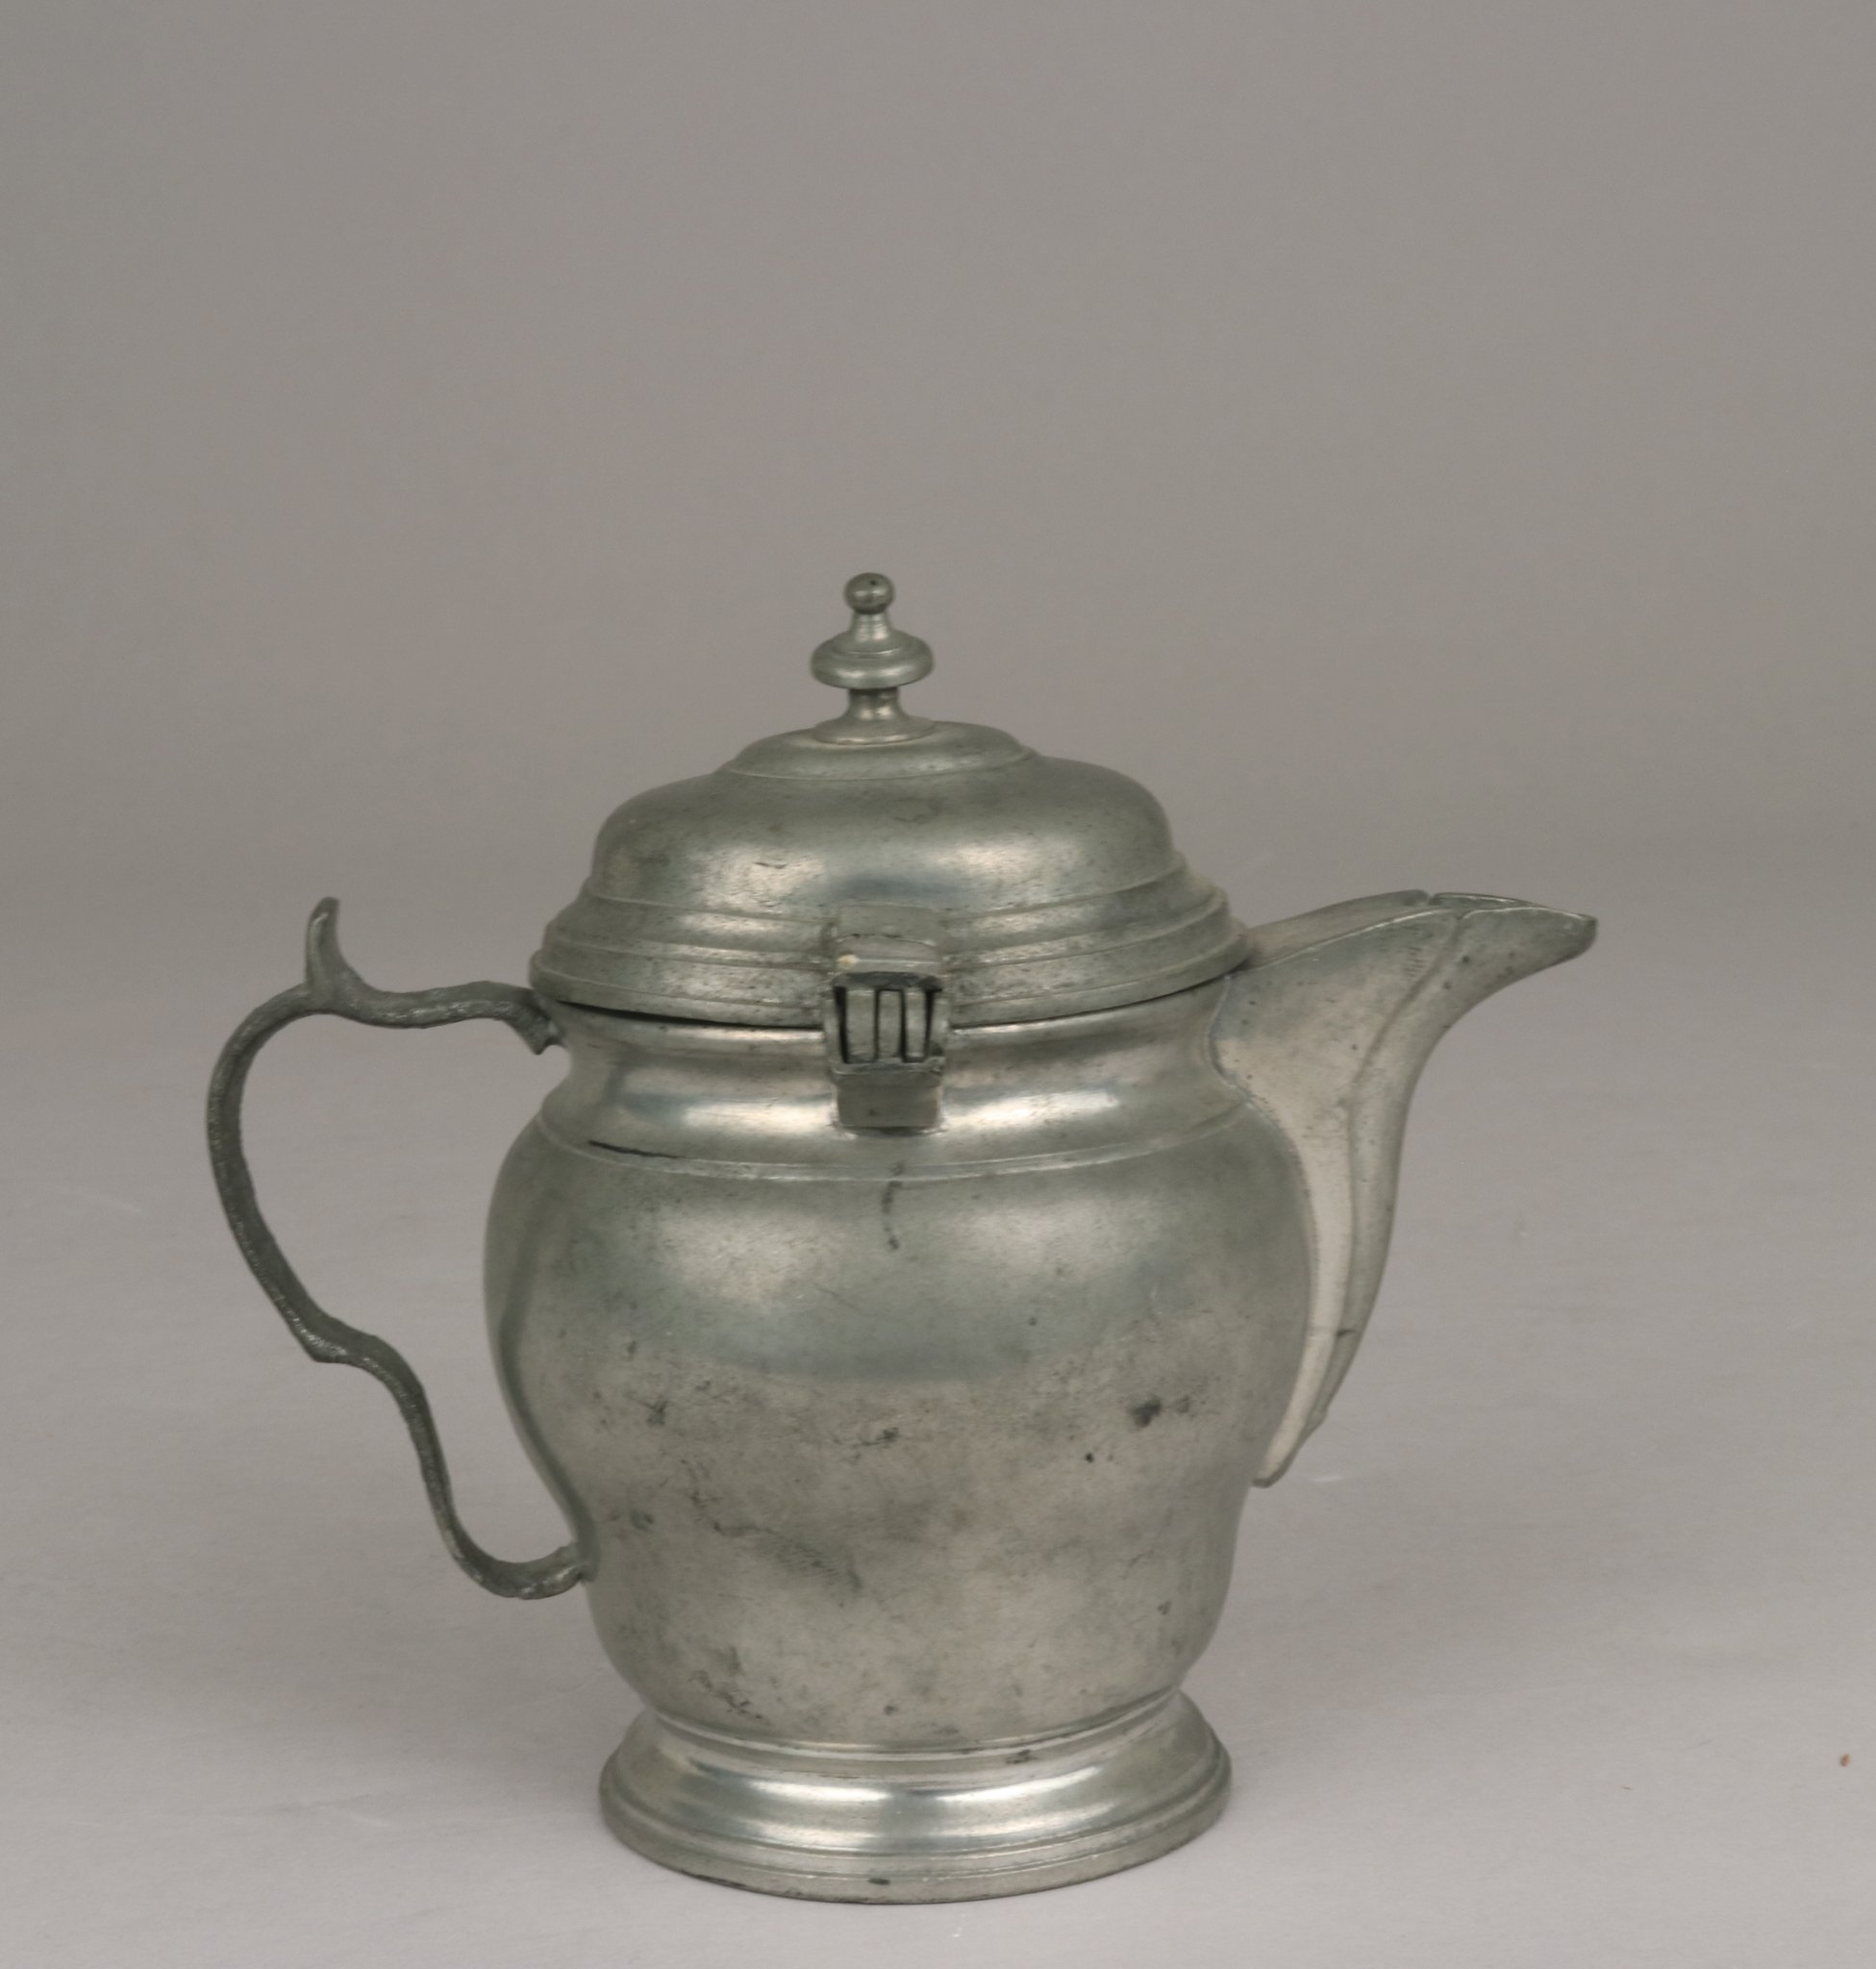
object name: coffeepot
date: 1801-1900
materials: pewter